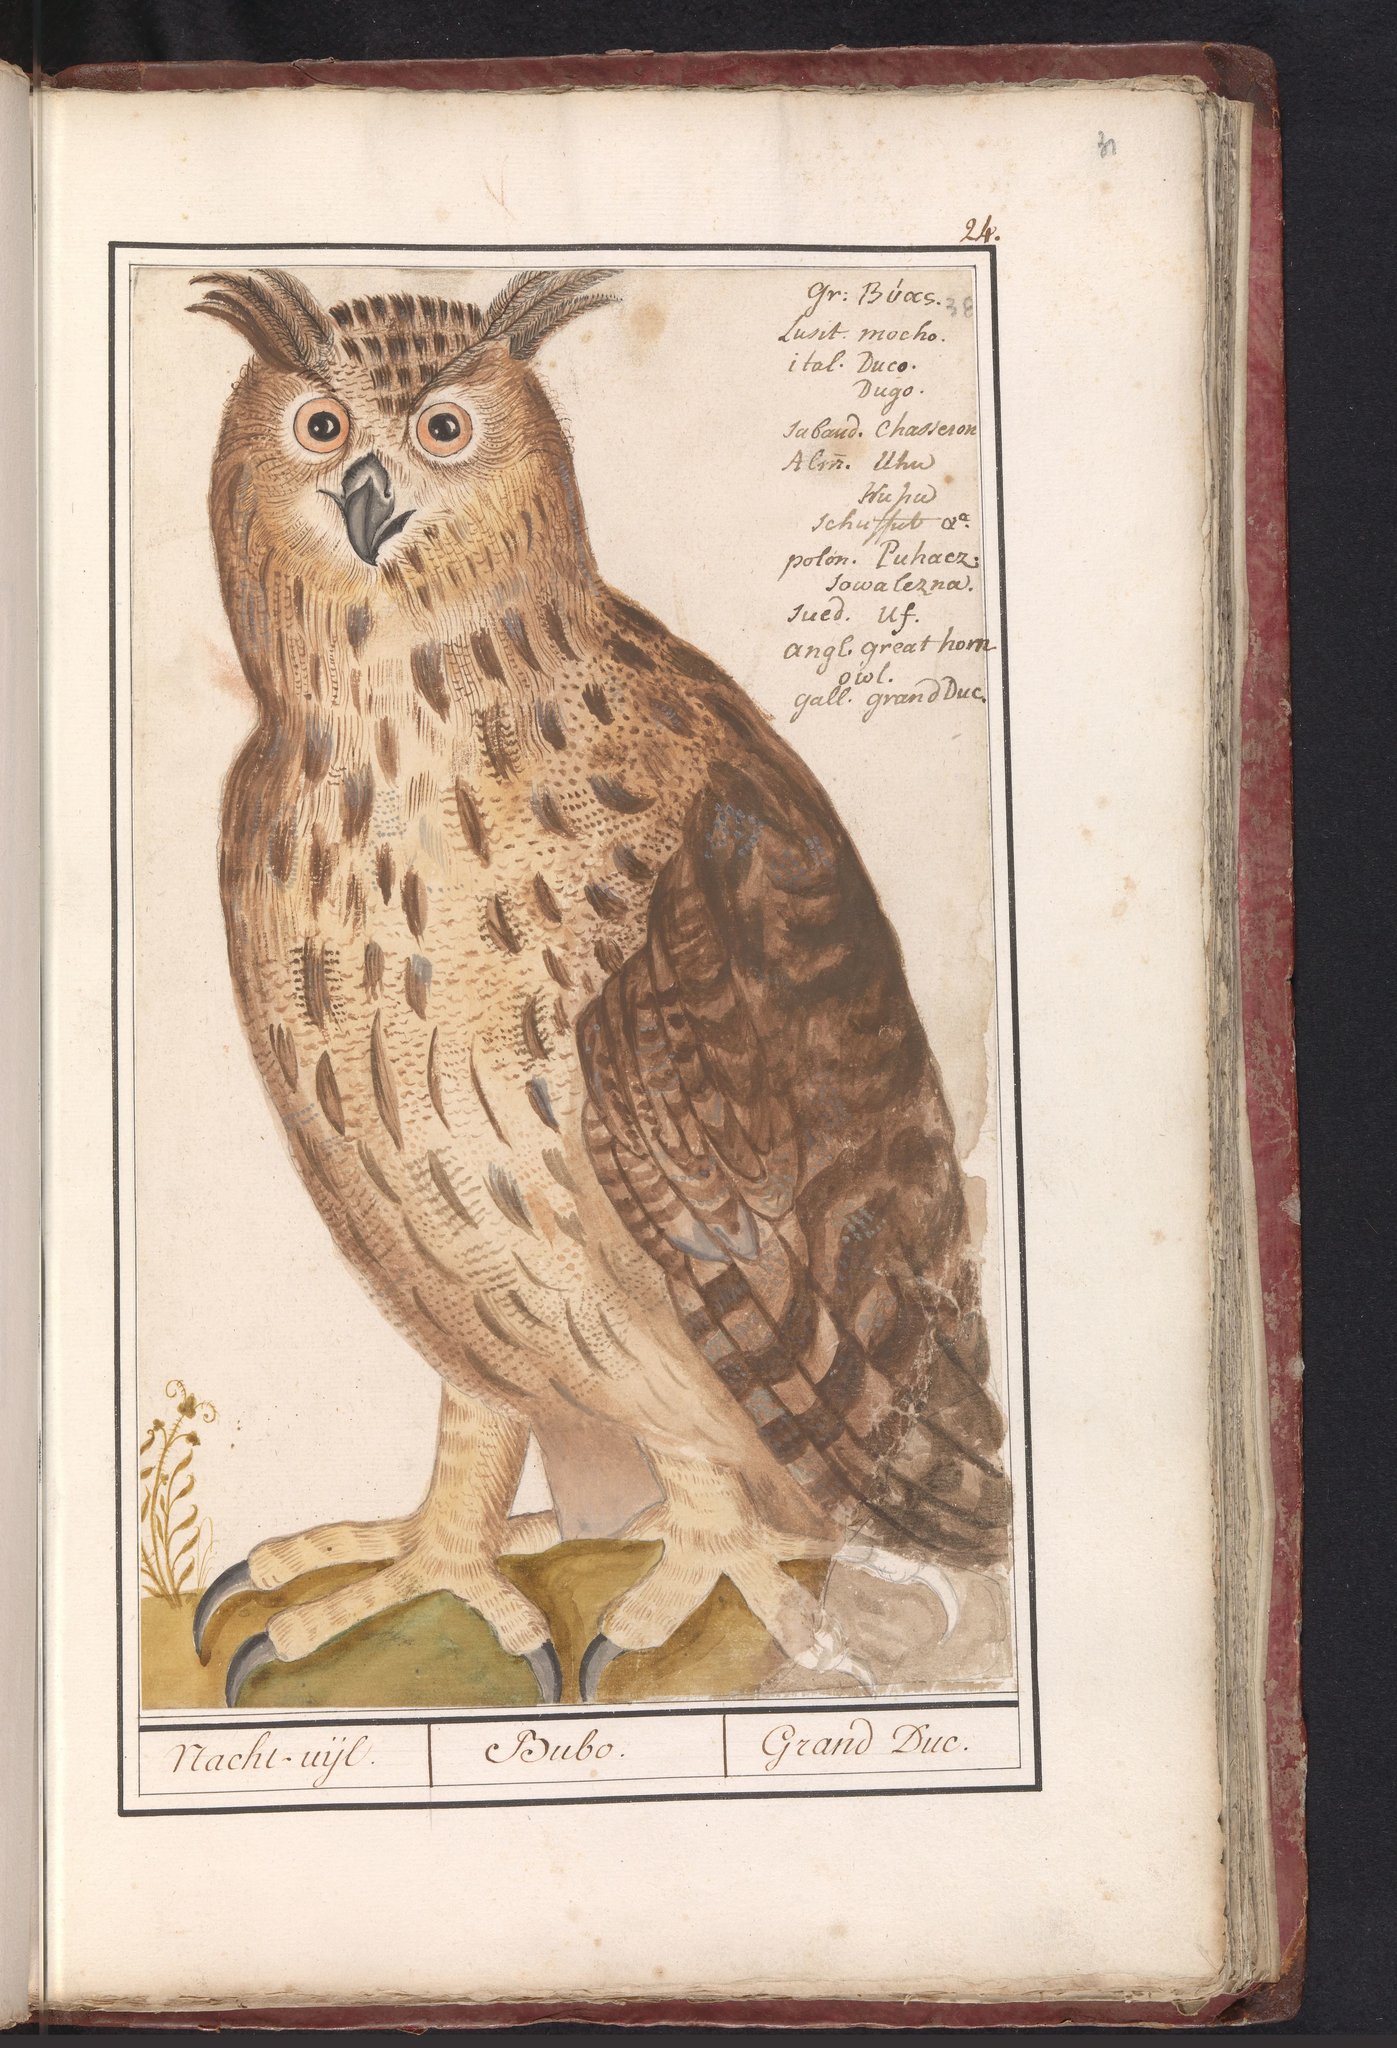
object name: drawing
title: Nacht-uijl. / Bubo. / Grand Duc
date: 1596-1610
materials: paint, ink, paper, pencil, watercolor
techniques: brush, pen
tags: owls: eurasian eagle-owl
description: Oehoe. Genummerd rechtsboven: 24. Rechtsboven de naam in negen talen. Onderdeel van het eerste album met tekeningen van vogels. Derde van twaalf albums met tekeningen van dieren, vogels en planten bekend rond 1600, gemaakt in opdracht van keizer Rudolf II. Met toelichting in Nederlands, Latijn en Frans.